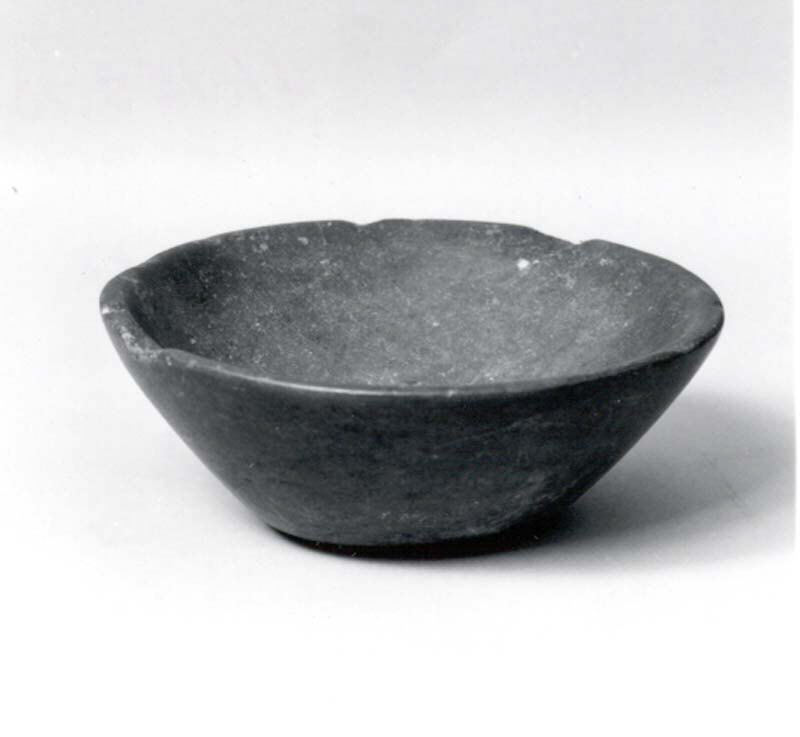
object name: vessel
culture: sumerian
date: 2900-2700 BCE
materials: stone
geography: mesopotamia